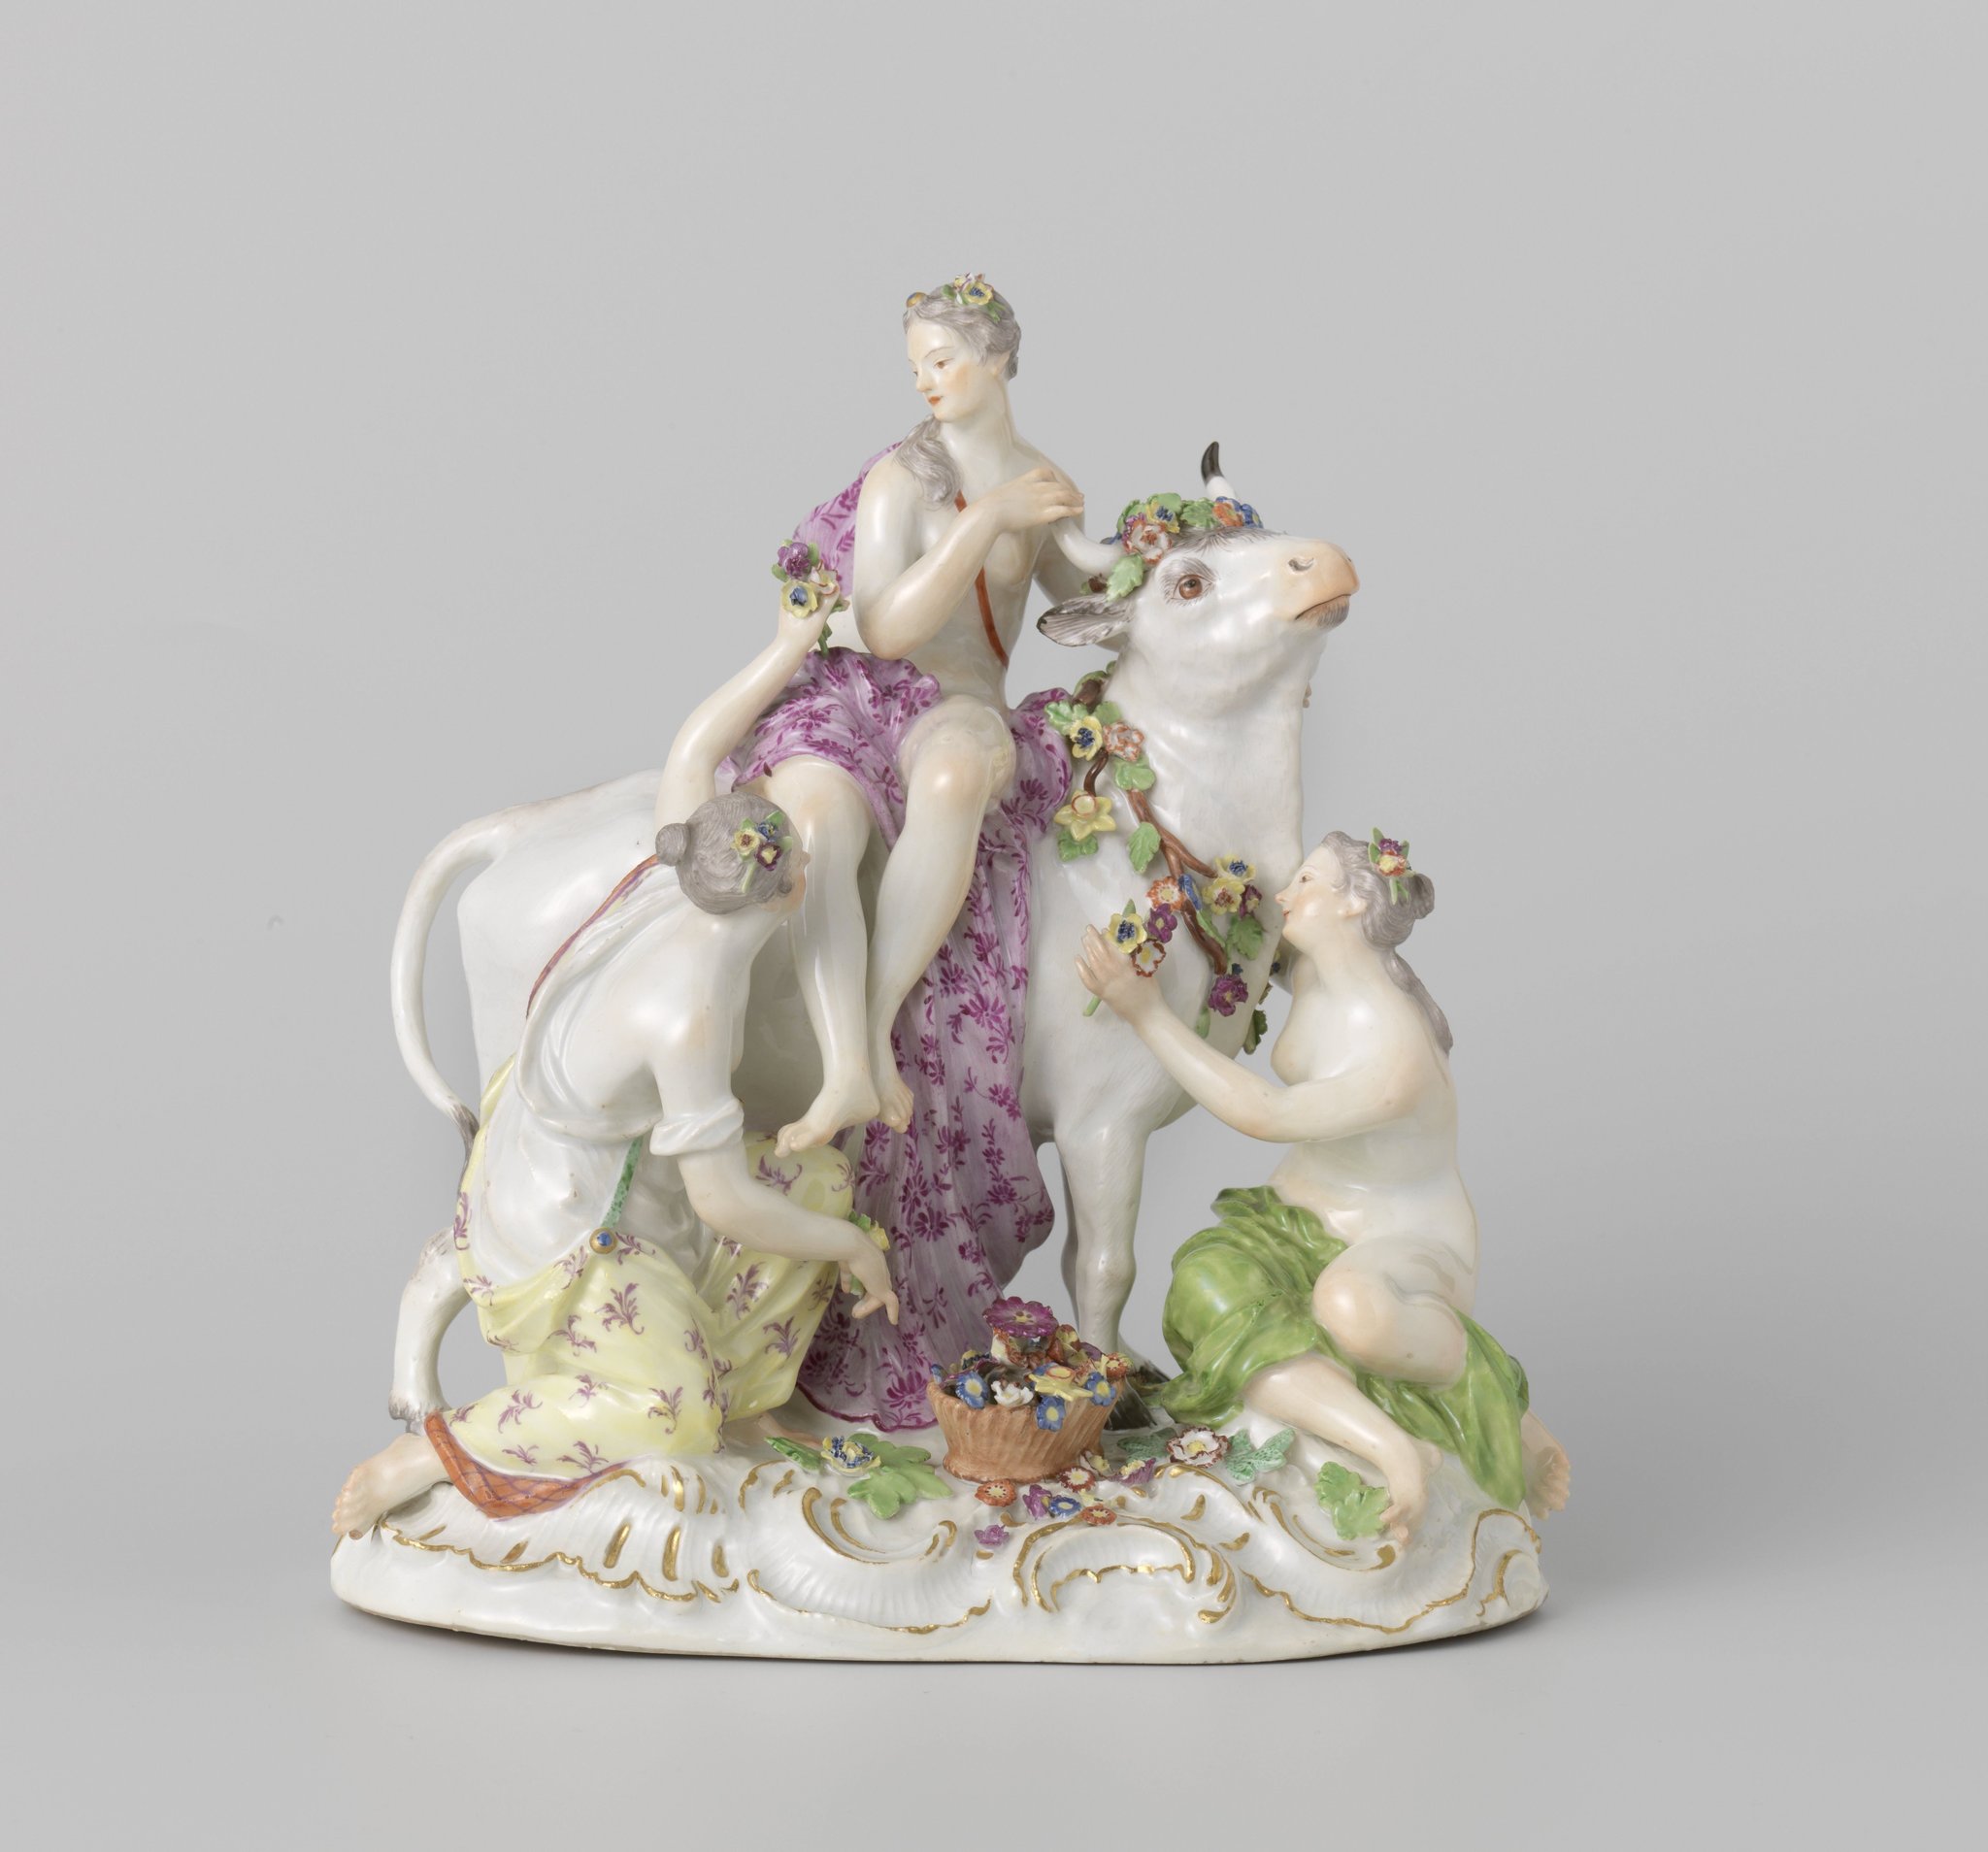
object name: figure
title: Europa op de stier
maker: friedrich elias meyer (i)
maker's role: sculptor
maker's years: 1723-1785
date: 1750-1760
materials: porcelain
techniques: painted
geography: meissen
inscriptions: factory mark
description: Europa and the bull. Porcelain. Meissen, c. 1760, the model possibly by Friedrich Elias Meyer. Mr and Mrs J.C.J. Drucker-Fraser bequest, 1944.